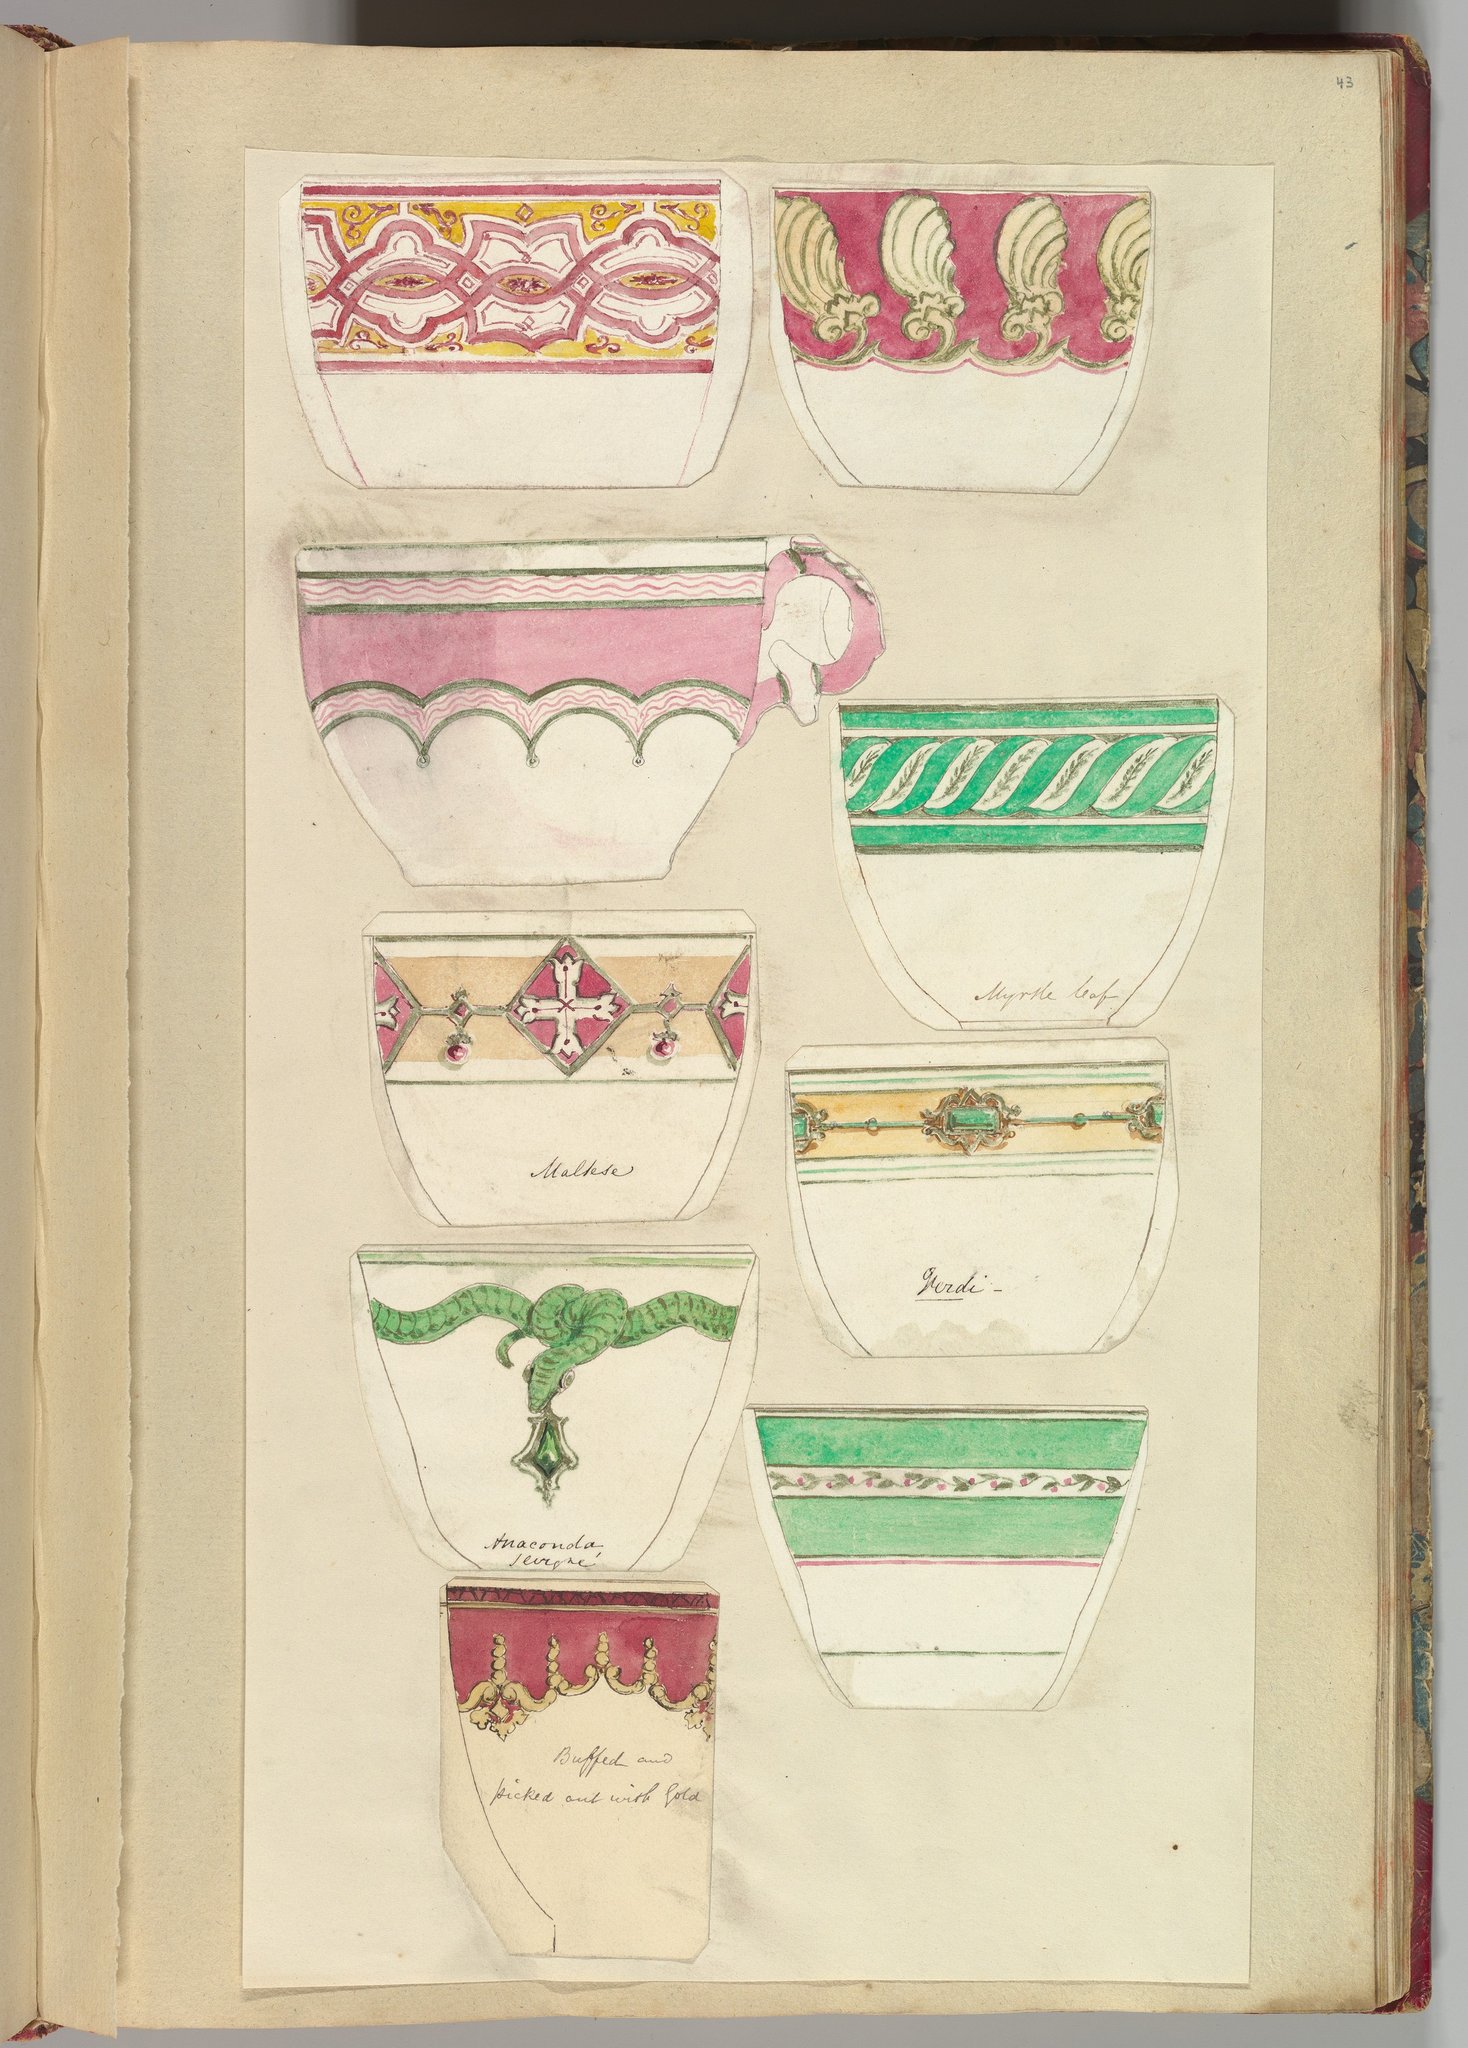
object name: drawing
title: Nine Designs for Decorated Cups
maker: alfred henry forrester [alfred crowquill]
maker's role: artist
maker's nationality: british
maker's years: 1804-1872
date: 1845-1855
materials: ink, watercolor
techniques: pen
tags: cups